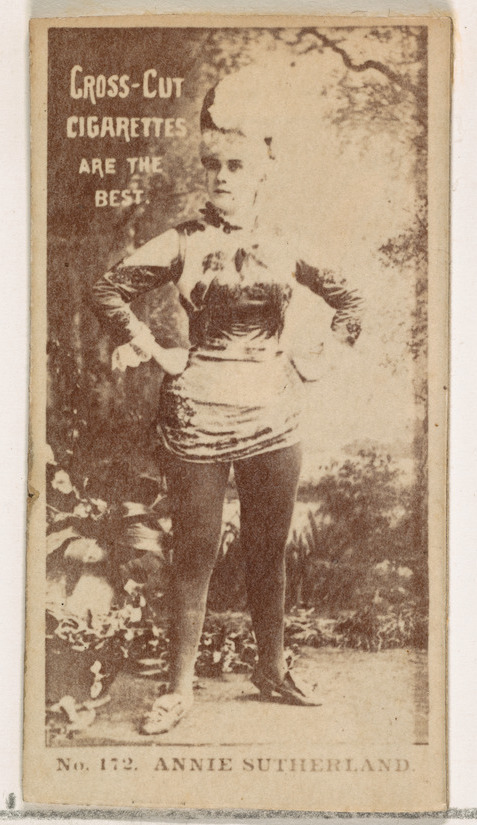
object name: print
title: Card Number 172, Annie Sutherland, from the Actors and Actresses series (N145-2) issued by Duke Sons & Co. to promote Cross Cut Cigarettes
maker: w. duke, sons & co.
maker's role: publisher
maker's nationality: american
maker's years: 1870-1920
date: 1880-1889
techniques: albumen silver print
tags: portraits,women,actresses